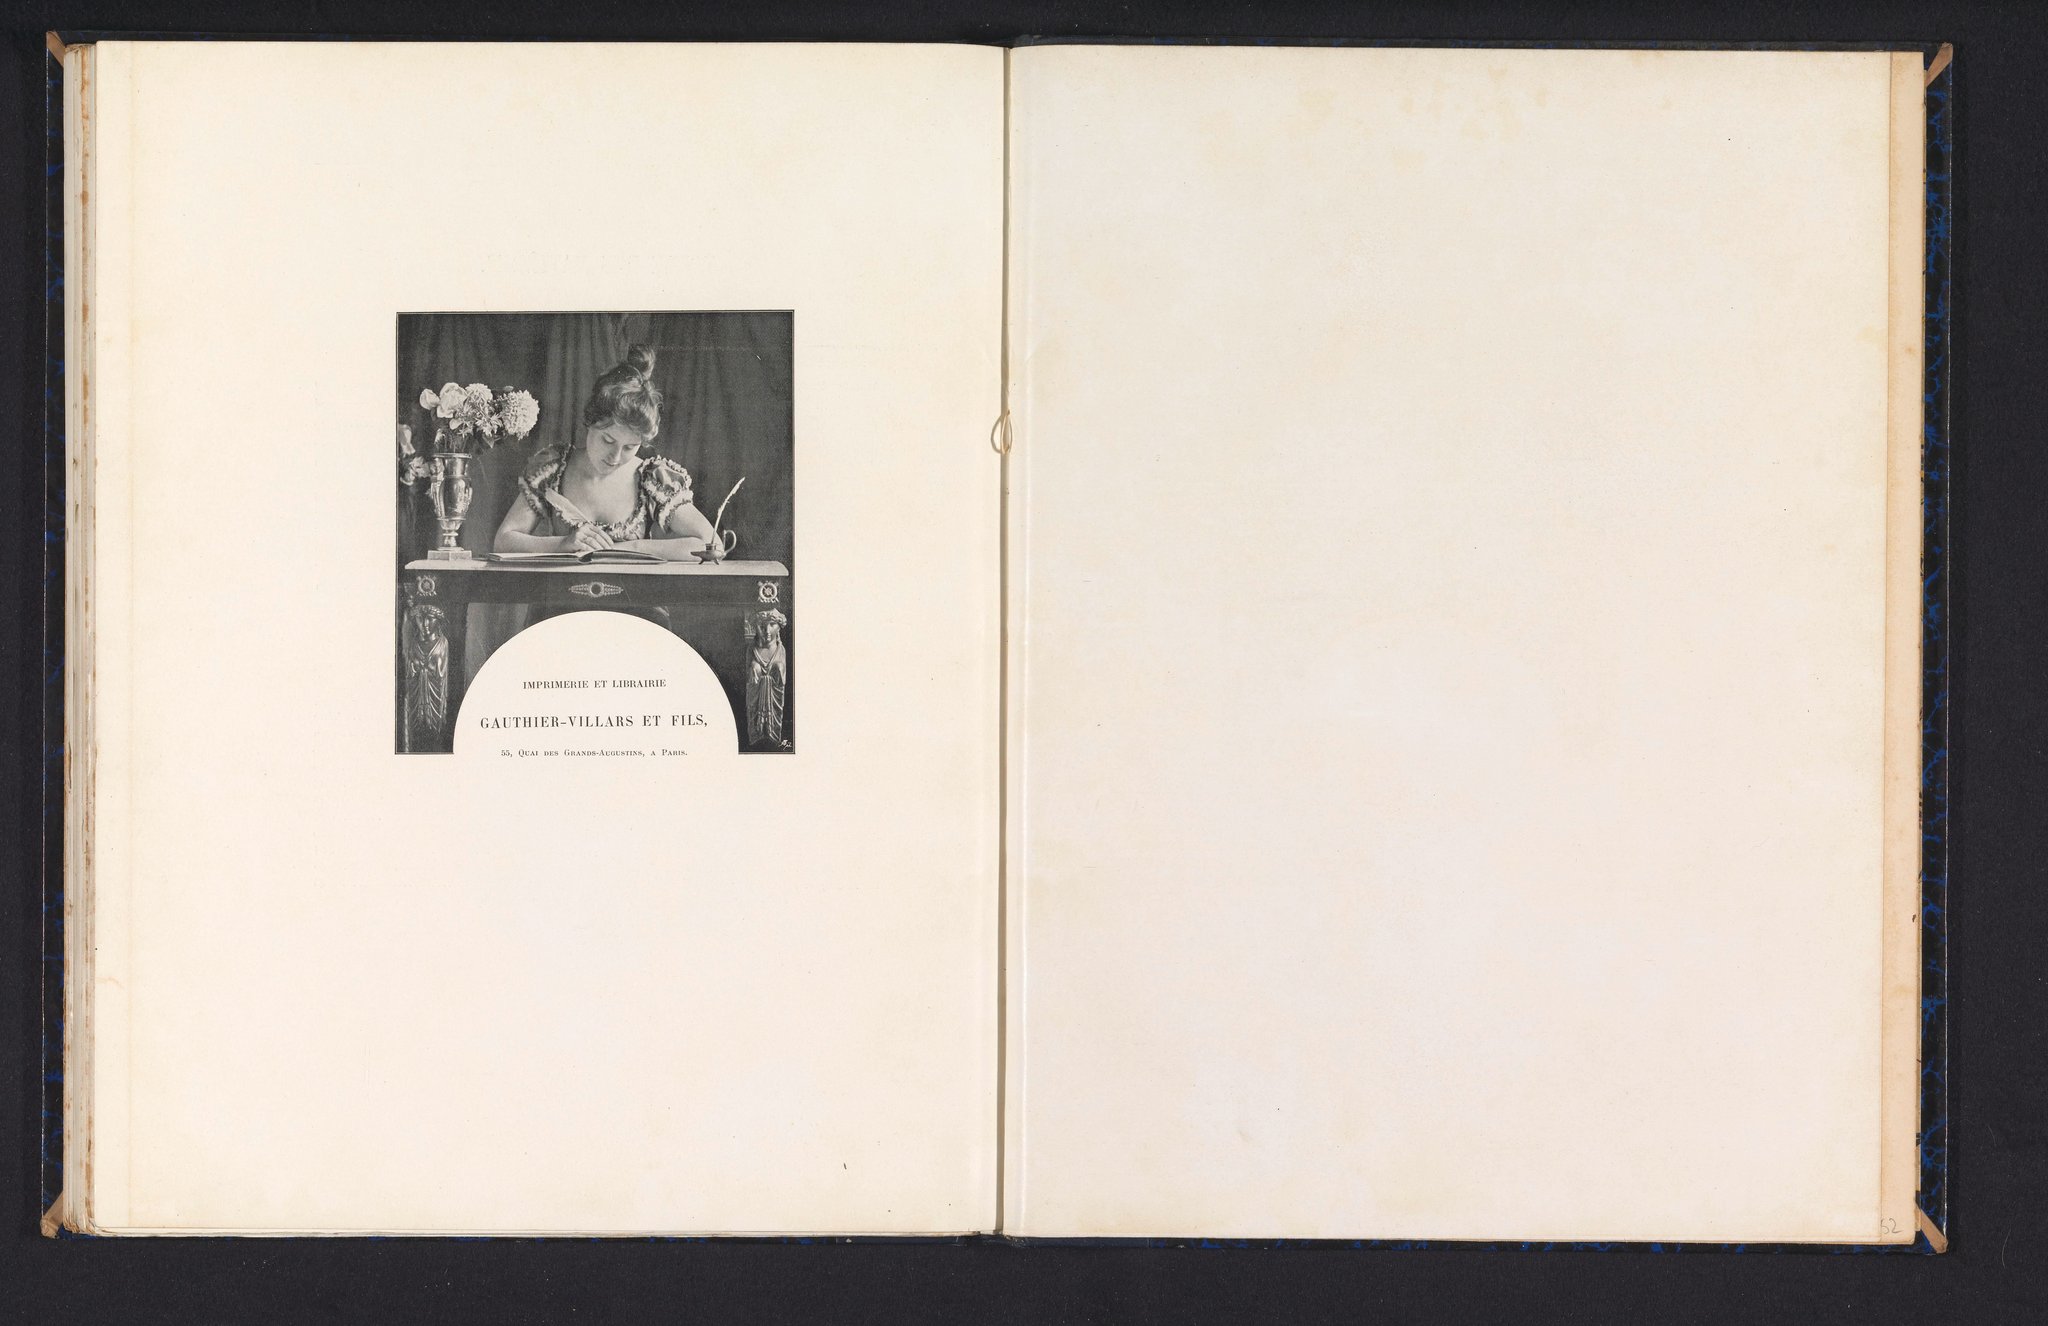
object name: photomechanical print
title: Schrijvende vrouw aan een tafel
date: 1886-1896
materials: paper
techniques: autotype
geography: france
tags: handwriting, writing as activity, adult woman, table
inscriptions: inscription: ‘Imprimerie et librairie Gauthier-Villars et fils, 55, Quai des Grands-Augustins, a Paris.’